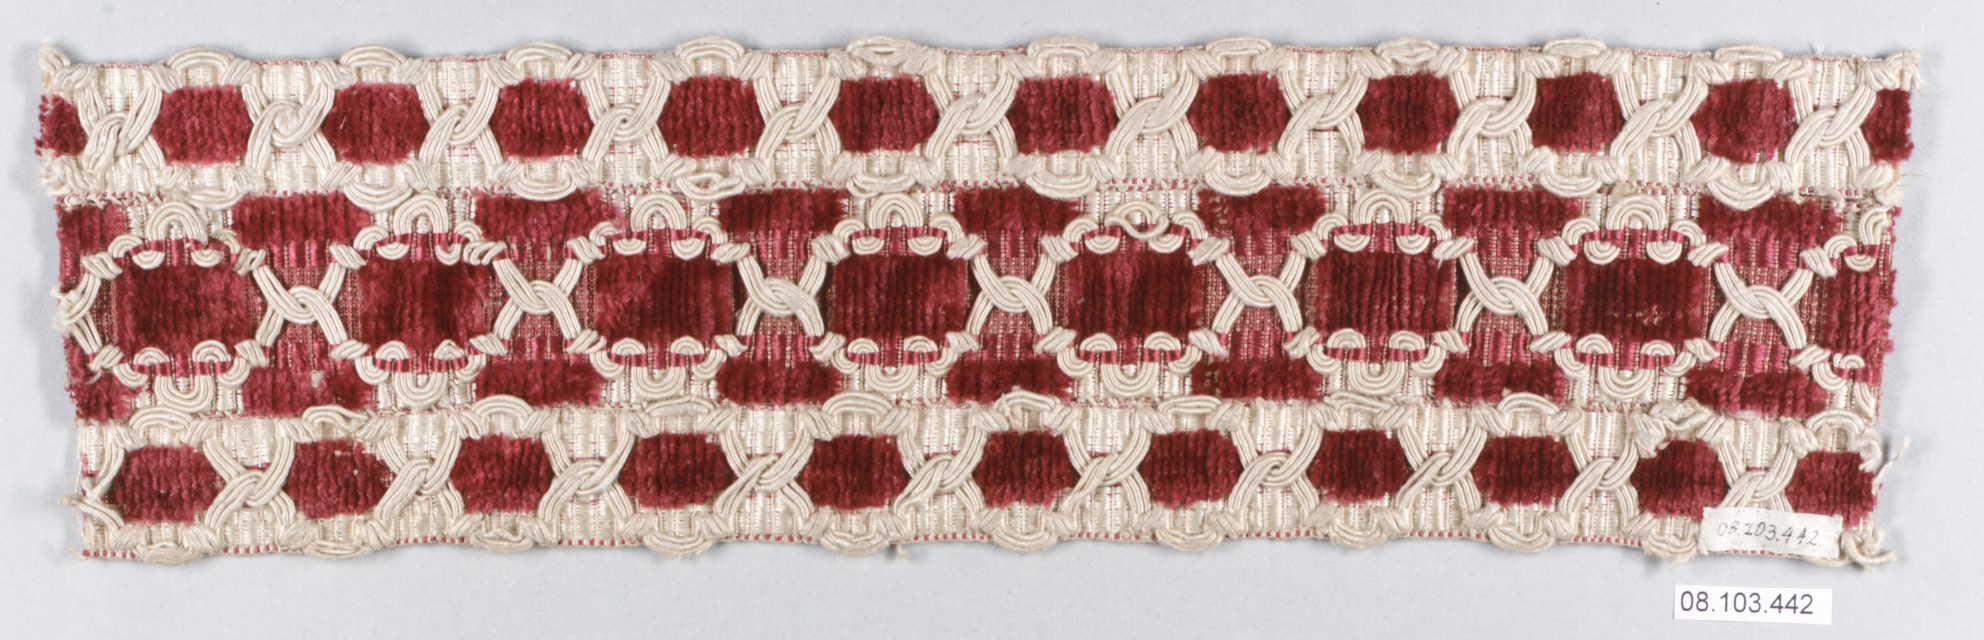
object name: galloon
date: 1701-1900